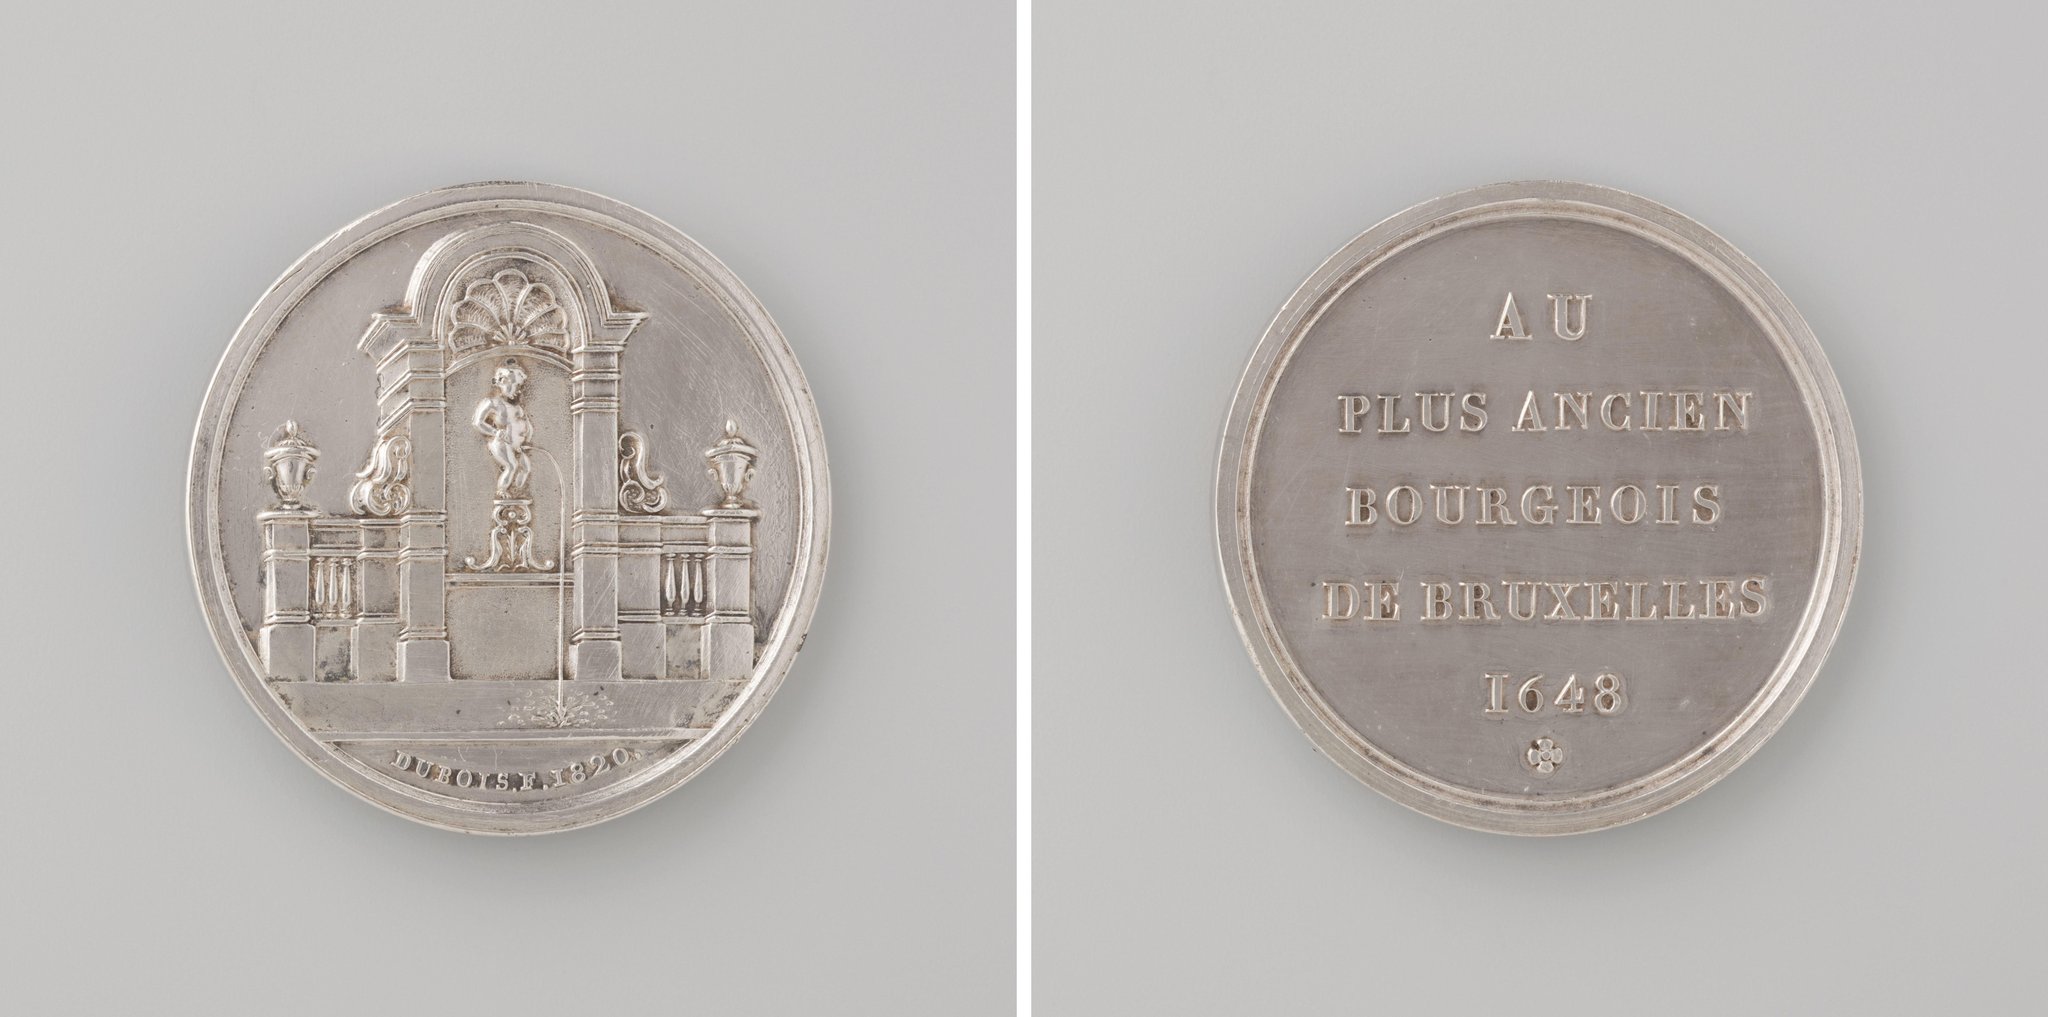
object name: history medal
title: Feest ter ere van Manneken Pis, de oudste burger van Brussel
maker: etienne jacques dubois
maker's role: medailleur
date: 1820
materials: silver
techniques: striking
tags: brussels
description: Zilveren penning. Voorzijde: plassend jongetje, voorstellende Manneken Pis, in siernis; afsnede: signatuur. Keerzijde: opschrift